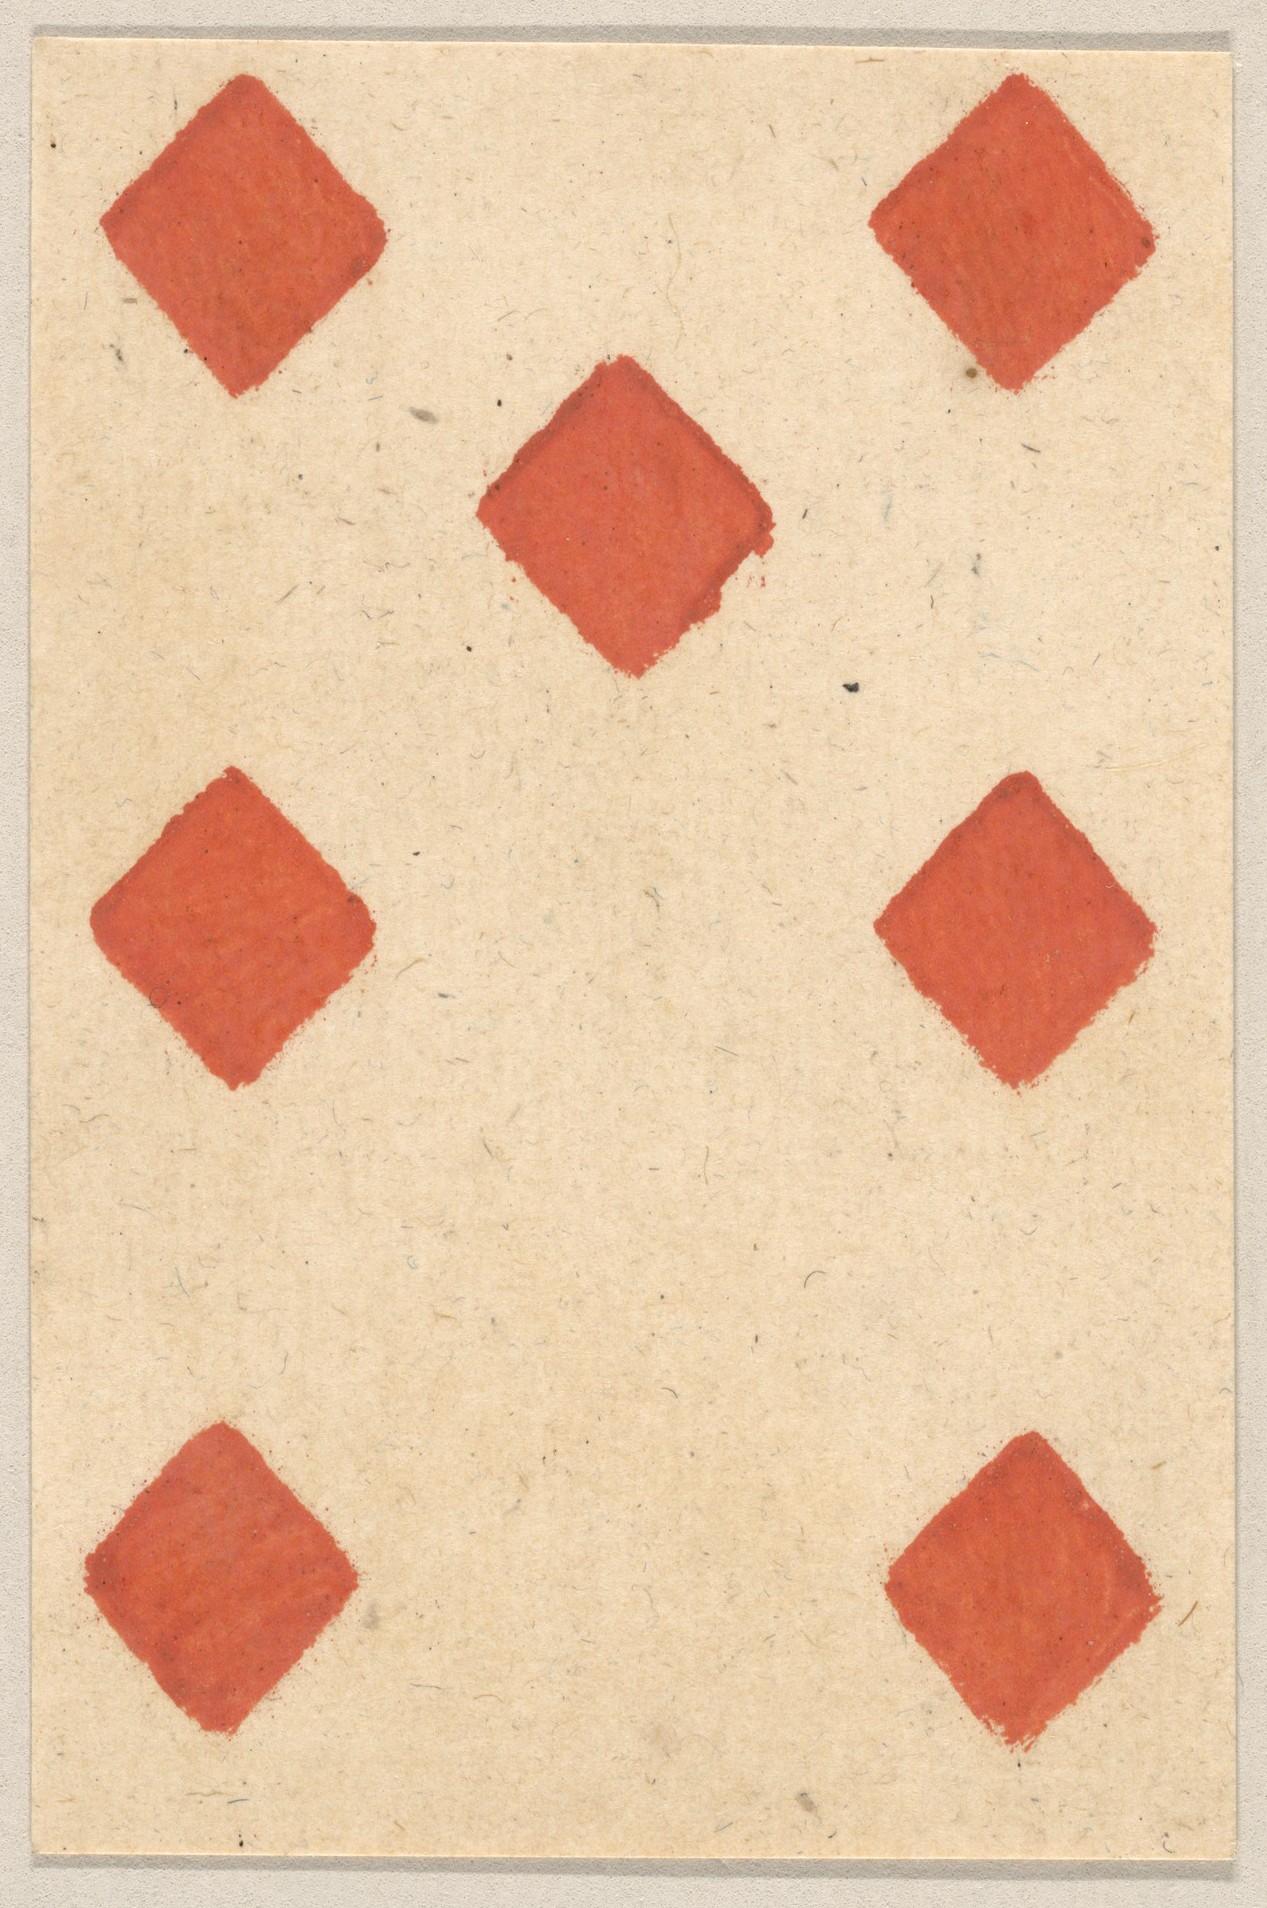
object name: print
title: Seven of Diamonds, from a Set of Piquet Cards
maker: claude fayolle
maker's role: artist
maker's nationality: french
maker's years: 1752-1826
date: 1767-1900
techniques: hand coloring, woodcut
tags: playing cards